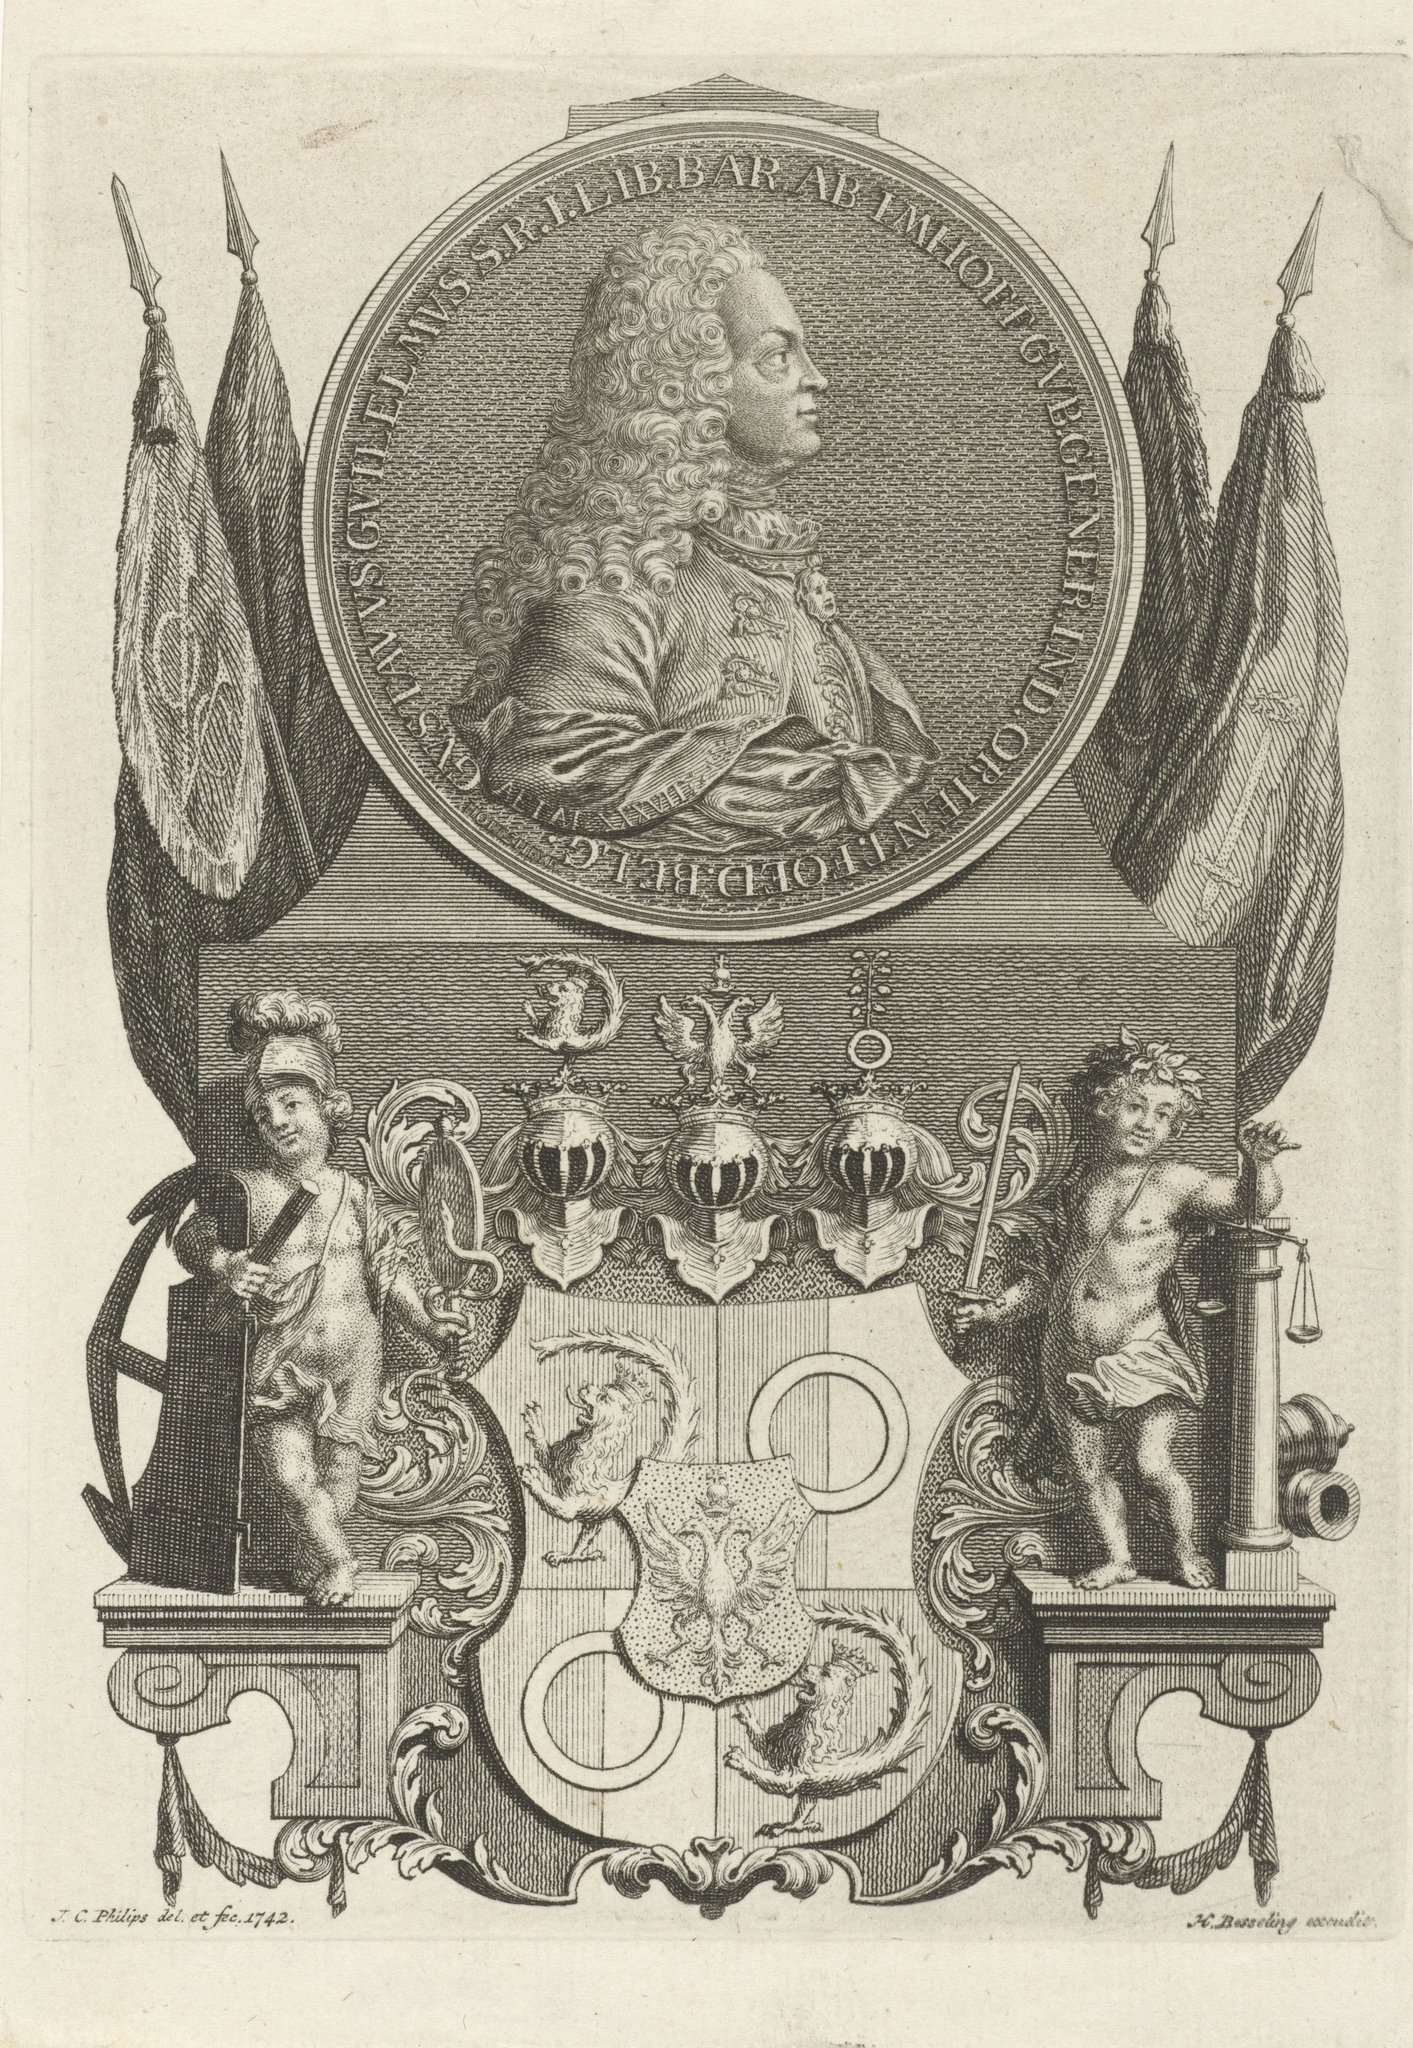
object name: print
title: Portret van Gustaaf Willem, baron van Imhoff (I)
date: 1742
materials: paper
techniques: engraving, etching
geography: amsterdam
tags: batavia, coat of arms (symbol of sovereignty), justice, 'justitia'; 'giustitia divina' (ripa) ~ one of the four cardinal virtues (+ variant), prudence, 'prudentia'; 'prudenza' (ripa) ~ one of the four cardinal virtues (+ variant)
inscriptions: collector's mark: Lugt 2228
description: Medaille met het portret van gouverneur-generaal Gustaaf Willem, baron van Imhoff (I). Onder het portret zijn wapenschild, dat wordt geflankeerd door putti met de attributen van Voorzichtigheid en Rechtvaardigheid.